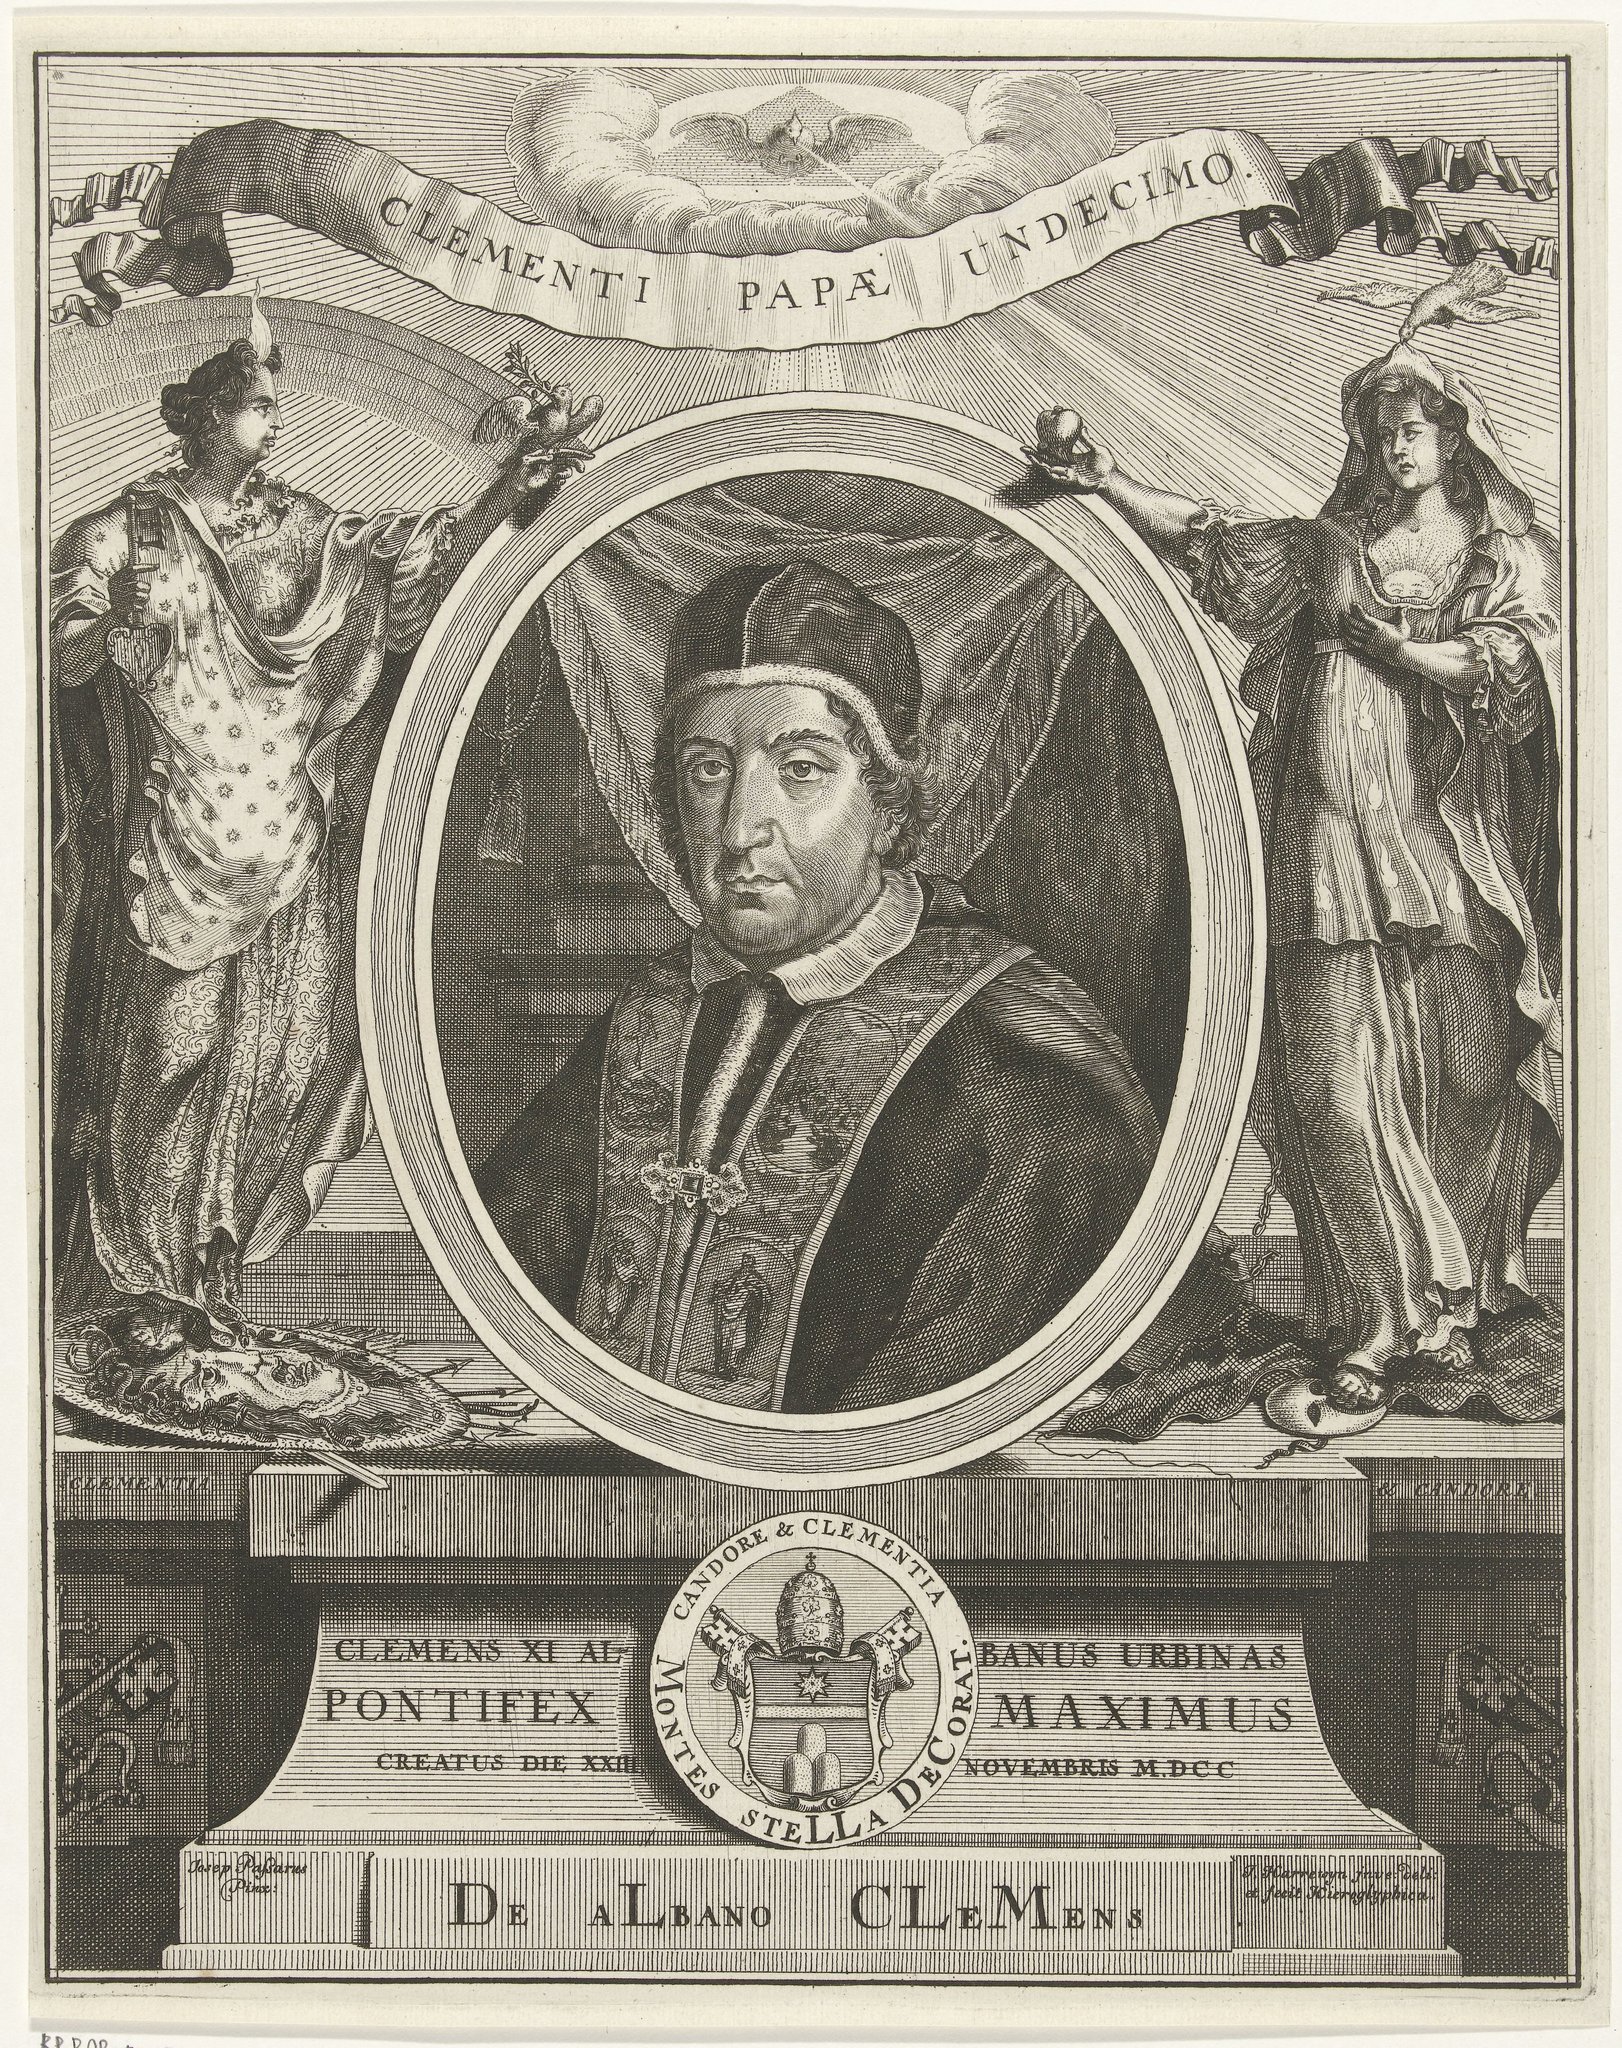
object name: print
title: Portret van Clemens XI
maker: jacobus harrewijn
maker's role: print maker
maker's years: 1660-1740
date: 1700-1721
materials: paper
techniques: engraving, etching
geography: low countries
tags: rome, clergyman, clemens xi, pope, symbols of the trinity ~ circular and/or triangular forms or arrangements, abstract ideas and concepts (+ personification), holy ghost represented as a dove (in flames)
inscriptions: collector's mark: Lugt 2228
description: Buste naar links van paus Clemens XI in een ovaal. Links van het portret de personificatie van vrede en trouw (Clementia) en rechts die van reinheid en deugdzaamheid (Candore). Boven het portret een lint met de naam. Daarboven de verbeelding van de Drieëenheid met de Heilige Geest als duif. Onder het portret zijn wapen en vier regels in het Latijn.